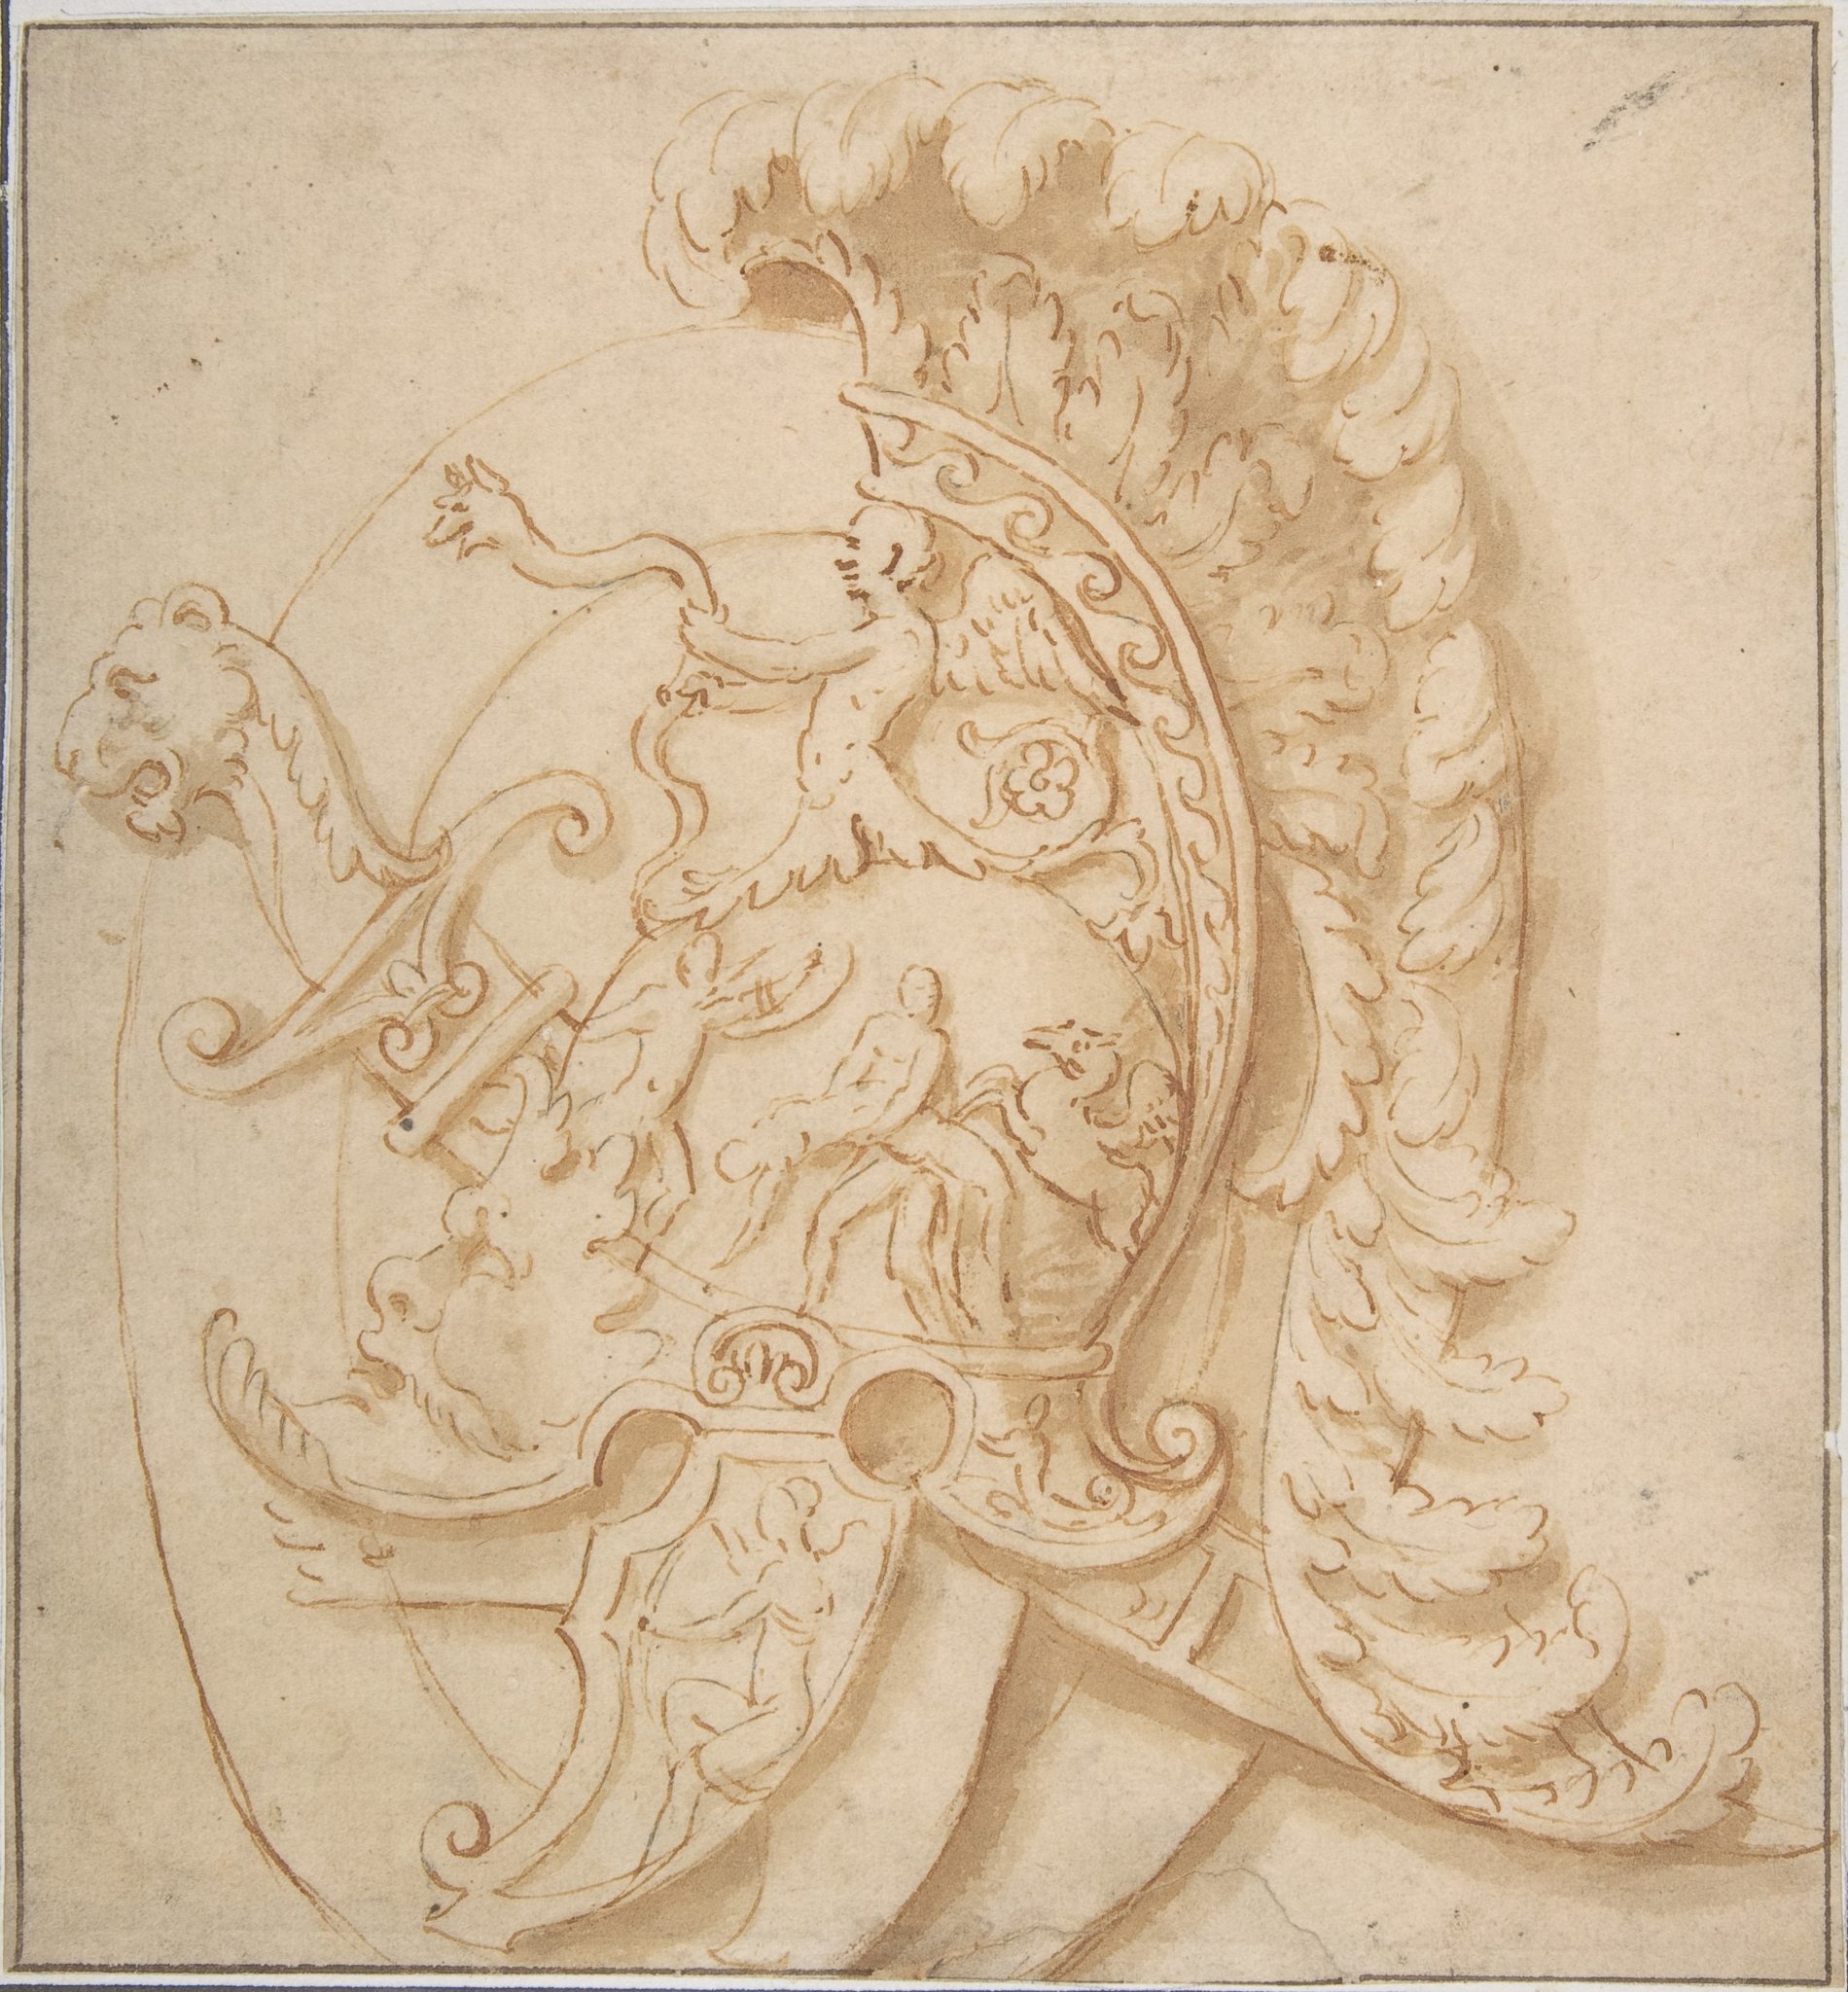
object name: drawing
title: Design for a Trophy with Sword and a Plumed Helmet Decorated with Grotesques Masks, Classical Motifs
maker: anonymous, italian, 17th century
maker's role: artist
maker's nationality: italian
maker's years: 1600-1700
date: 1601-1700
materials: ink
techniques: brush, pen, wash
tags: helmets,swords,grotesques